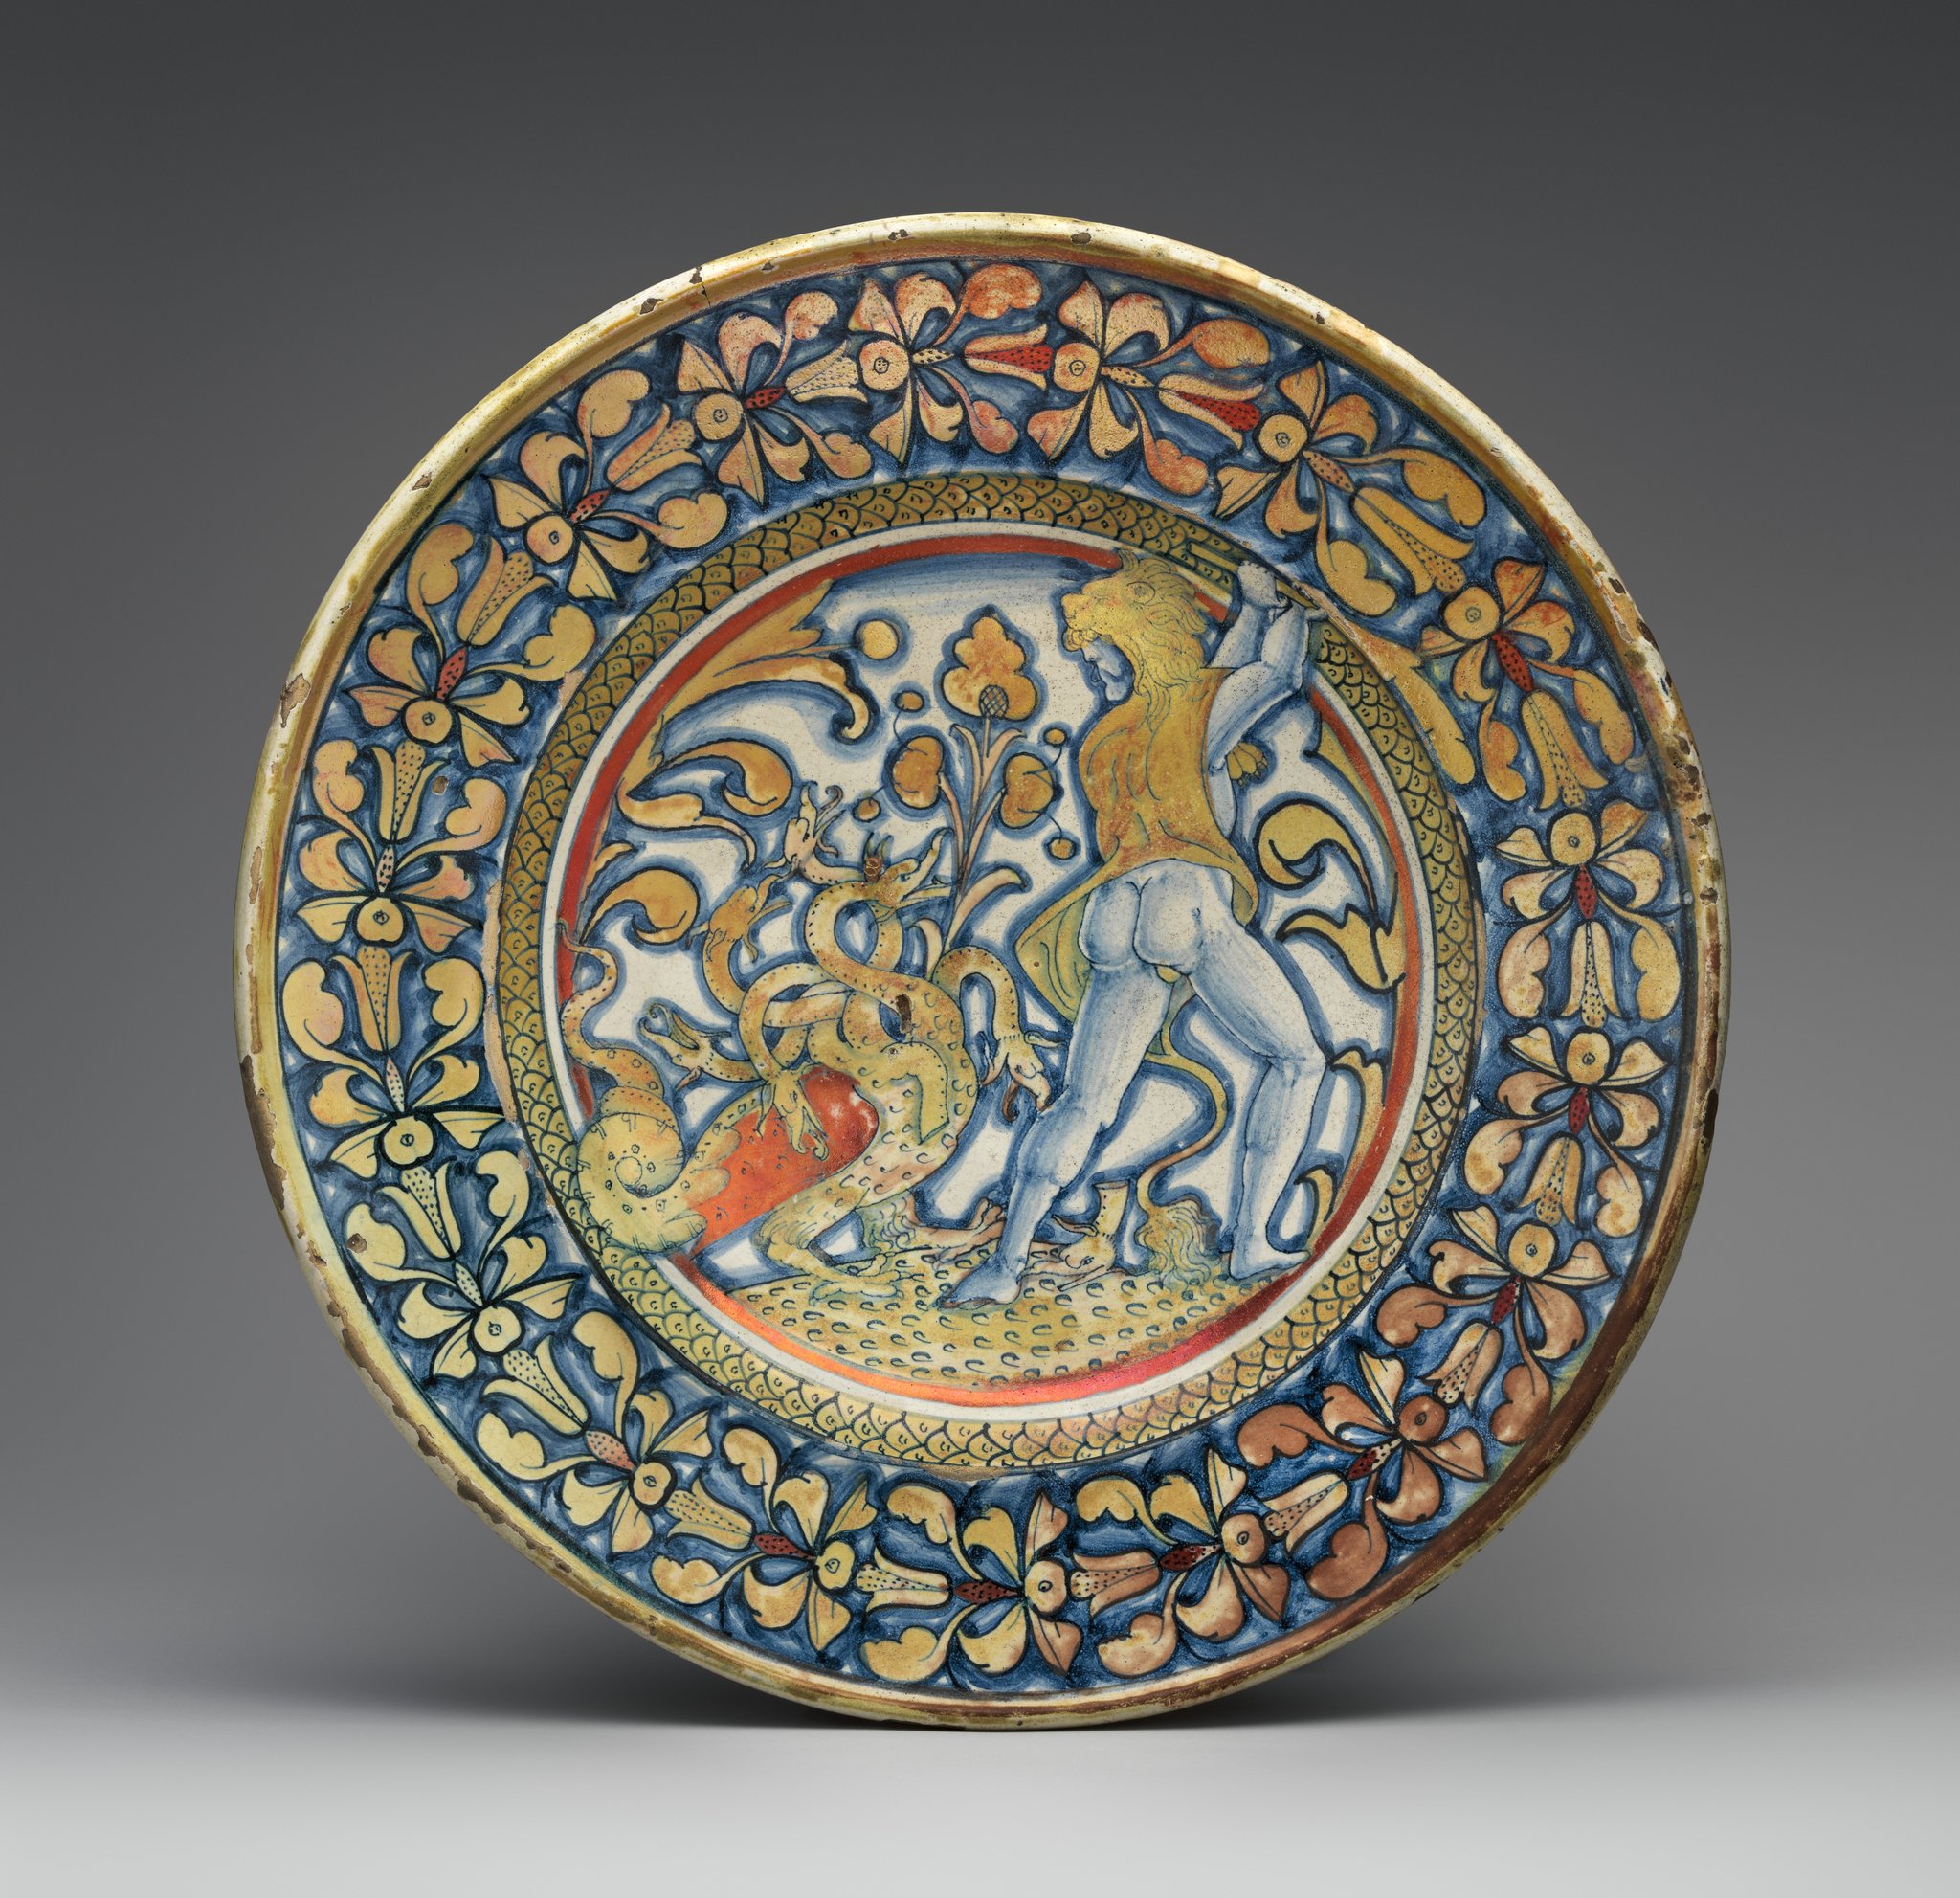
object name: dish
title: Dish (piatto)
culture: italian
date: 1530-1540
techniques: maiolica, glazing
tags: hercules